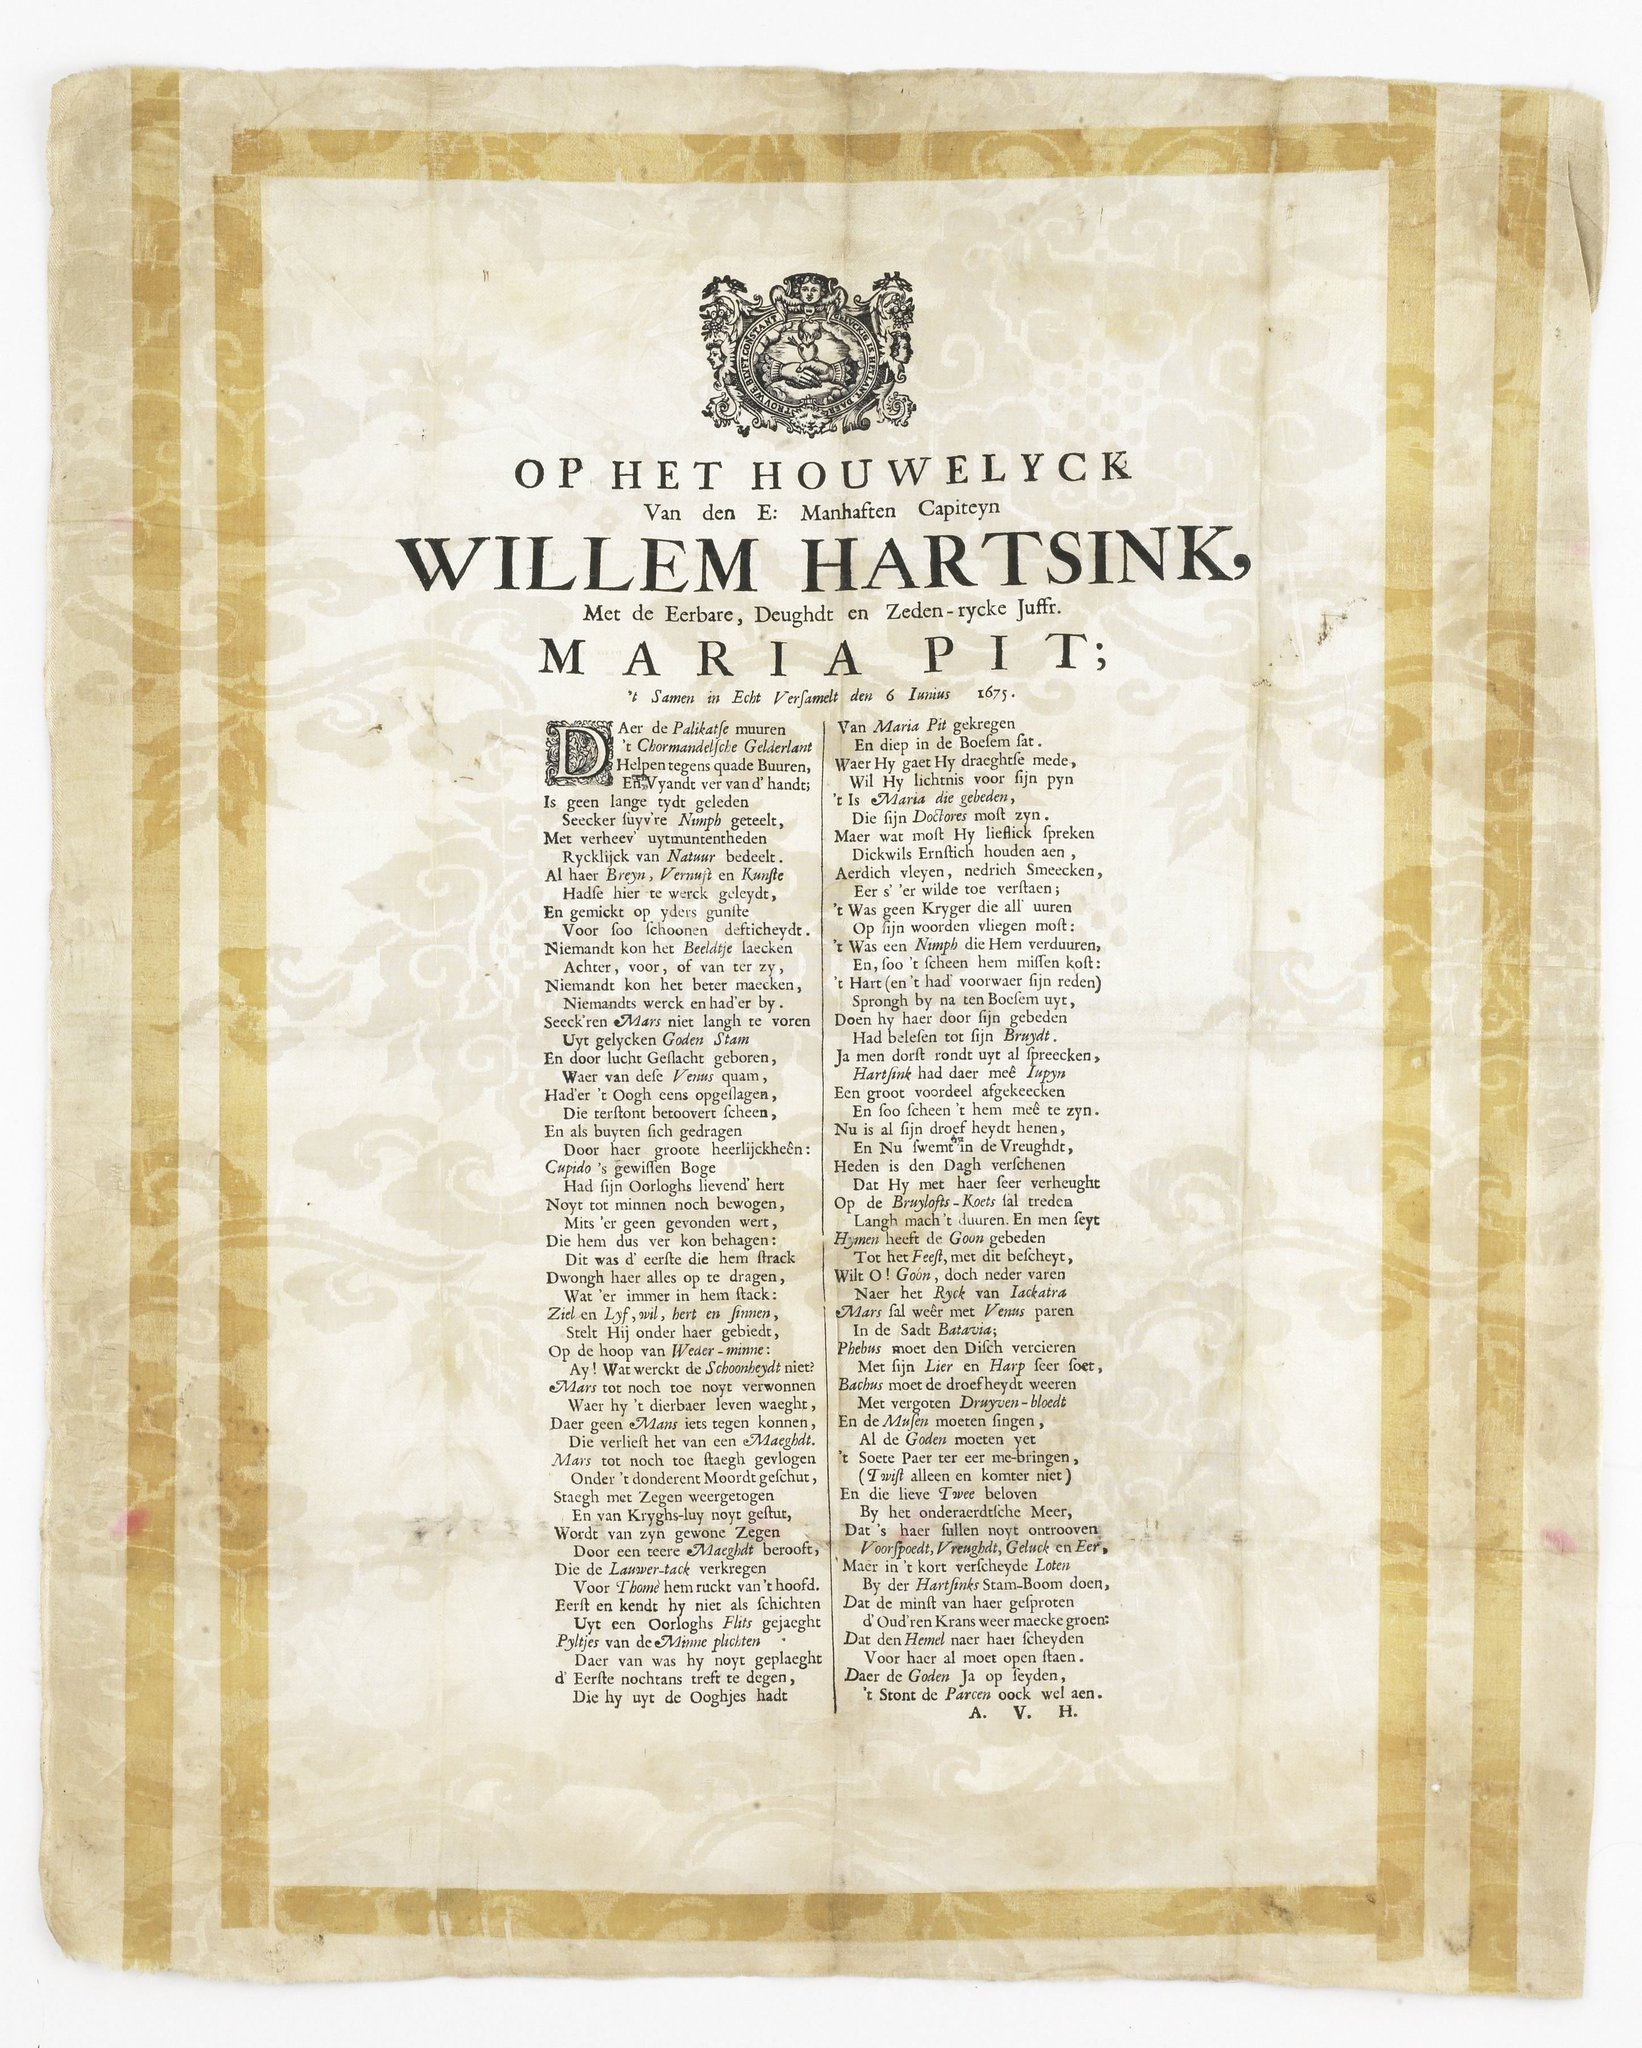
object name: cloth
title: Bedrukte doek met gedicht ter gelegenheid van het huwelijk van Maria Pit en Willem Hartsinck (Hartsink), 6 juni 1675 te Batavia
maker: monogrammist avh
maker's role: dichter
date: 1675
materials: silk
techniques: printing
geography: batavia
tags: batavia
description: Langwerpige damastzijden doek met Chinese motieven, bedrukt met een huwelijksgedicht in twee kolommen onder vier-regelige titel, waarboven vignet over huwelijkse trouw. In lijst.